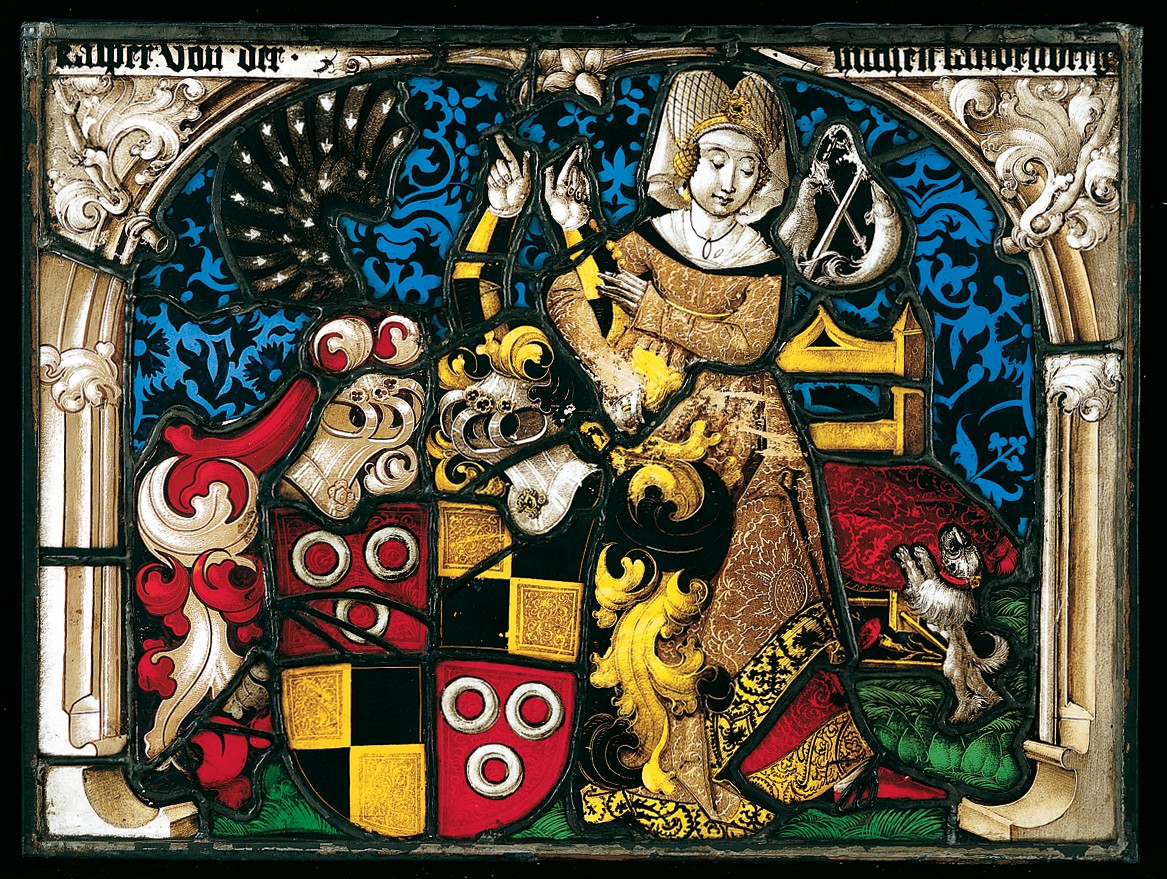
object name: panel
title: Stained-Glass Panel with a Coat of Arms and a Female Supporter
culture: swiss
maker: lukas zeiner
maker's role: artist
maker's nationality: swiss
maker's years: 1480-1510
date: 1500-1505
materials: glass, lead, metal, paint, pigment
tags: women,coat of arms